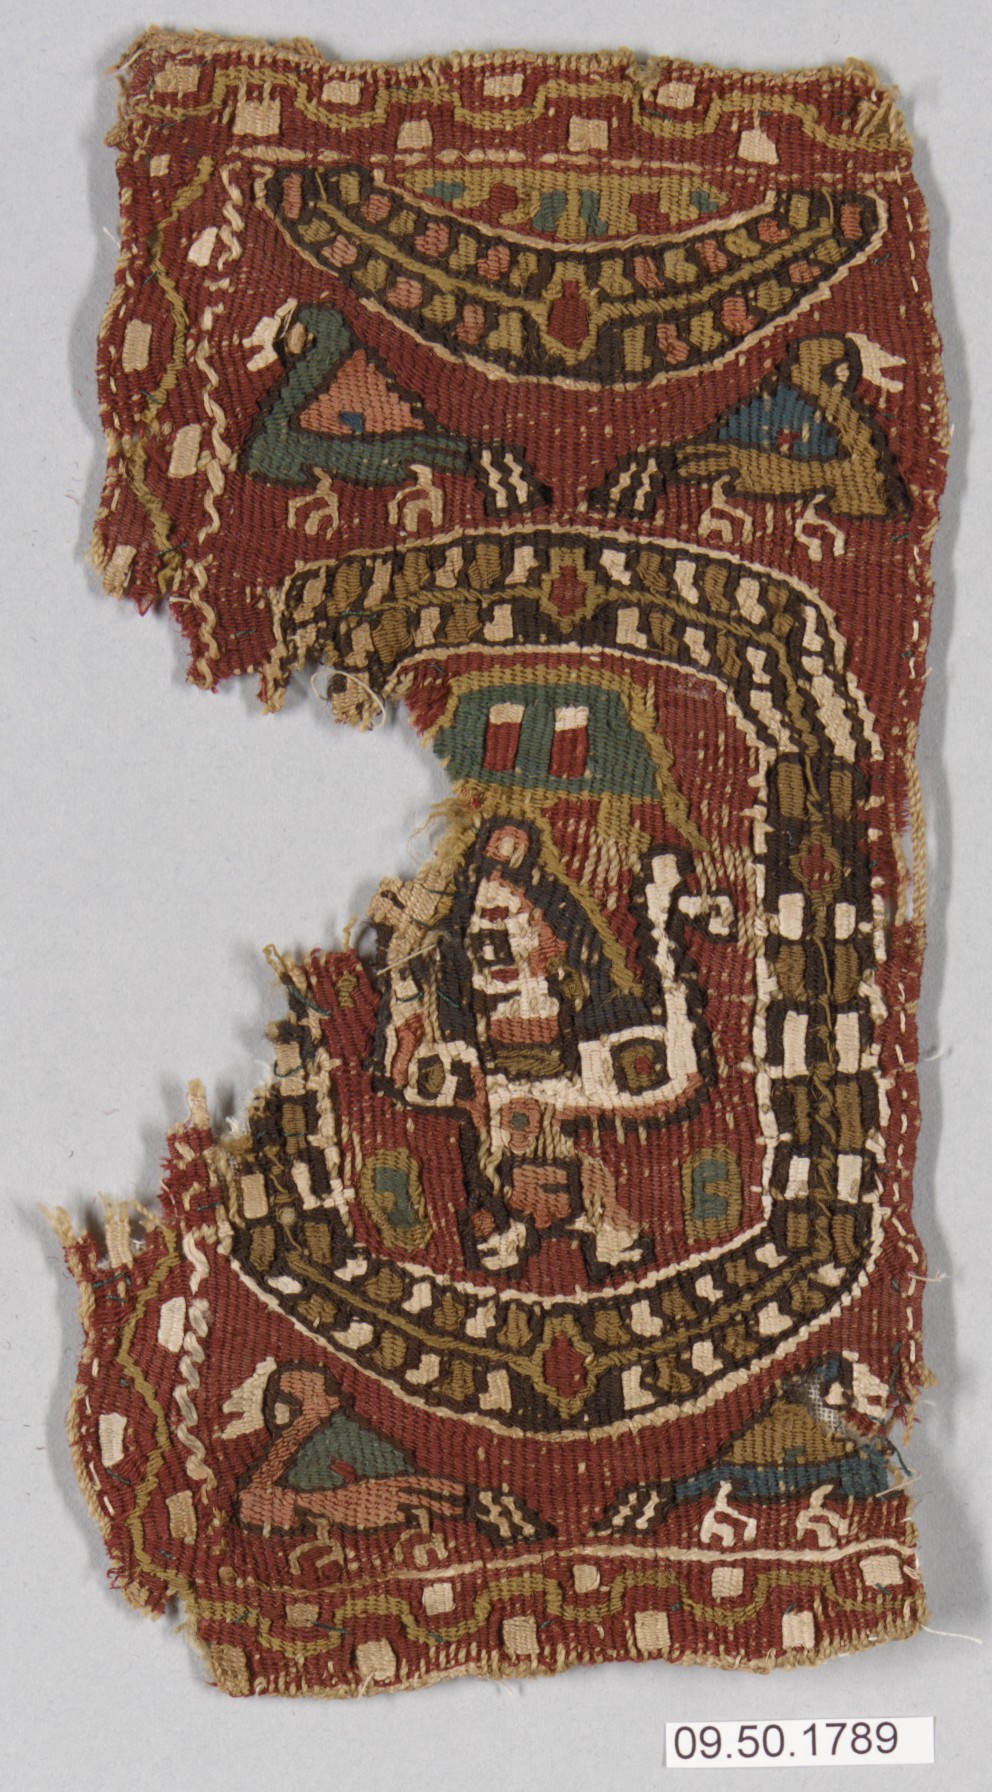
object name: band fragment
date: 501-700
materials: linen, wool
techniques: weave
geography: egypt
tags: birds